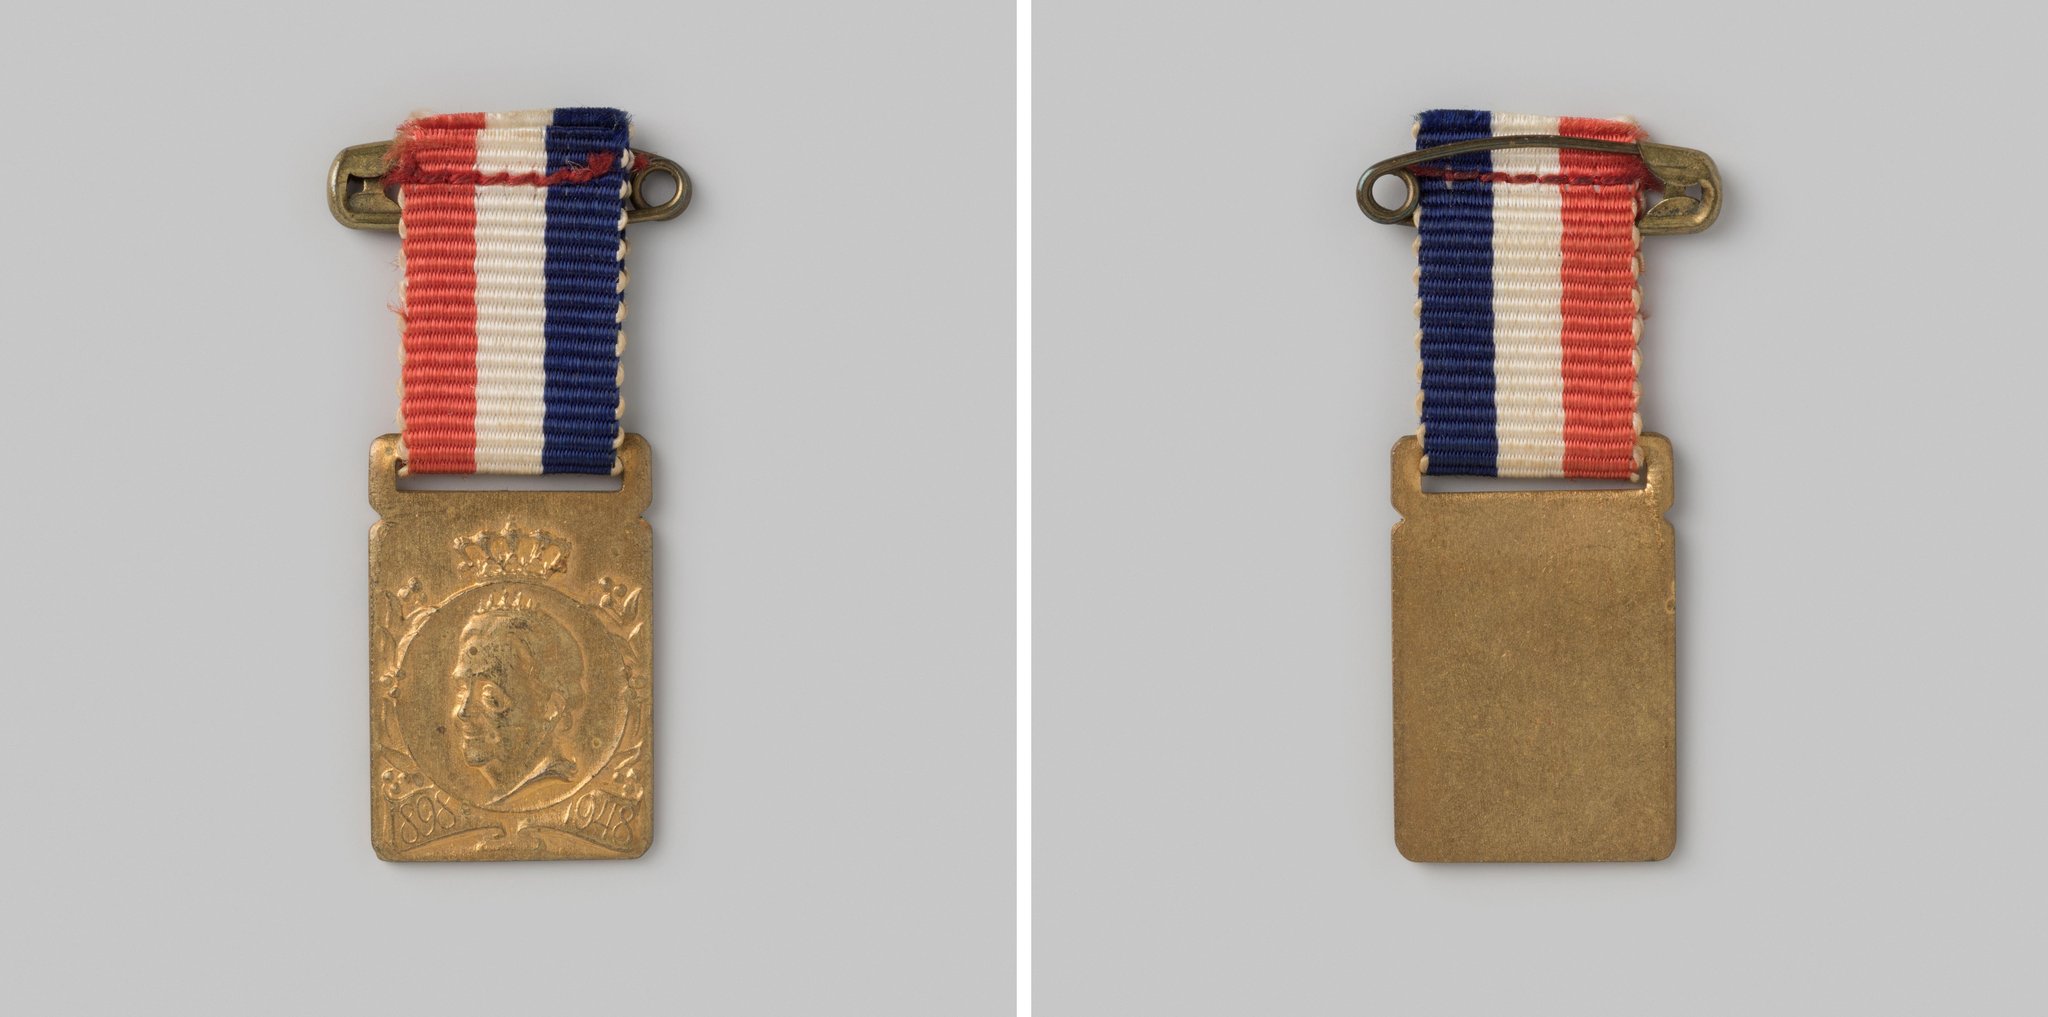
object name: insignia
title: Vijftigjarig regeringsjubileum van Koningin Wilhelmina 1948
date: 1948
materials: brass, textile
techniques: striking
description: Kleine rechthoekige messing plaquette aan rood-wit-blauw lint met veiligheidsspeld, op de voorzijde een gekroond medaillon met het portret van Wilhelmina half naar links tussen lauwertakken op een banderol, de keerzijde blanco.